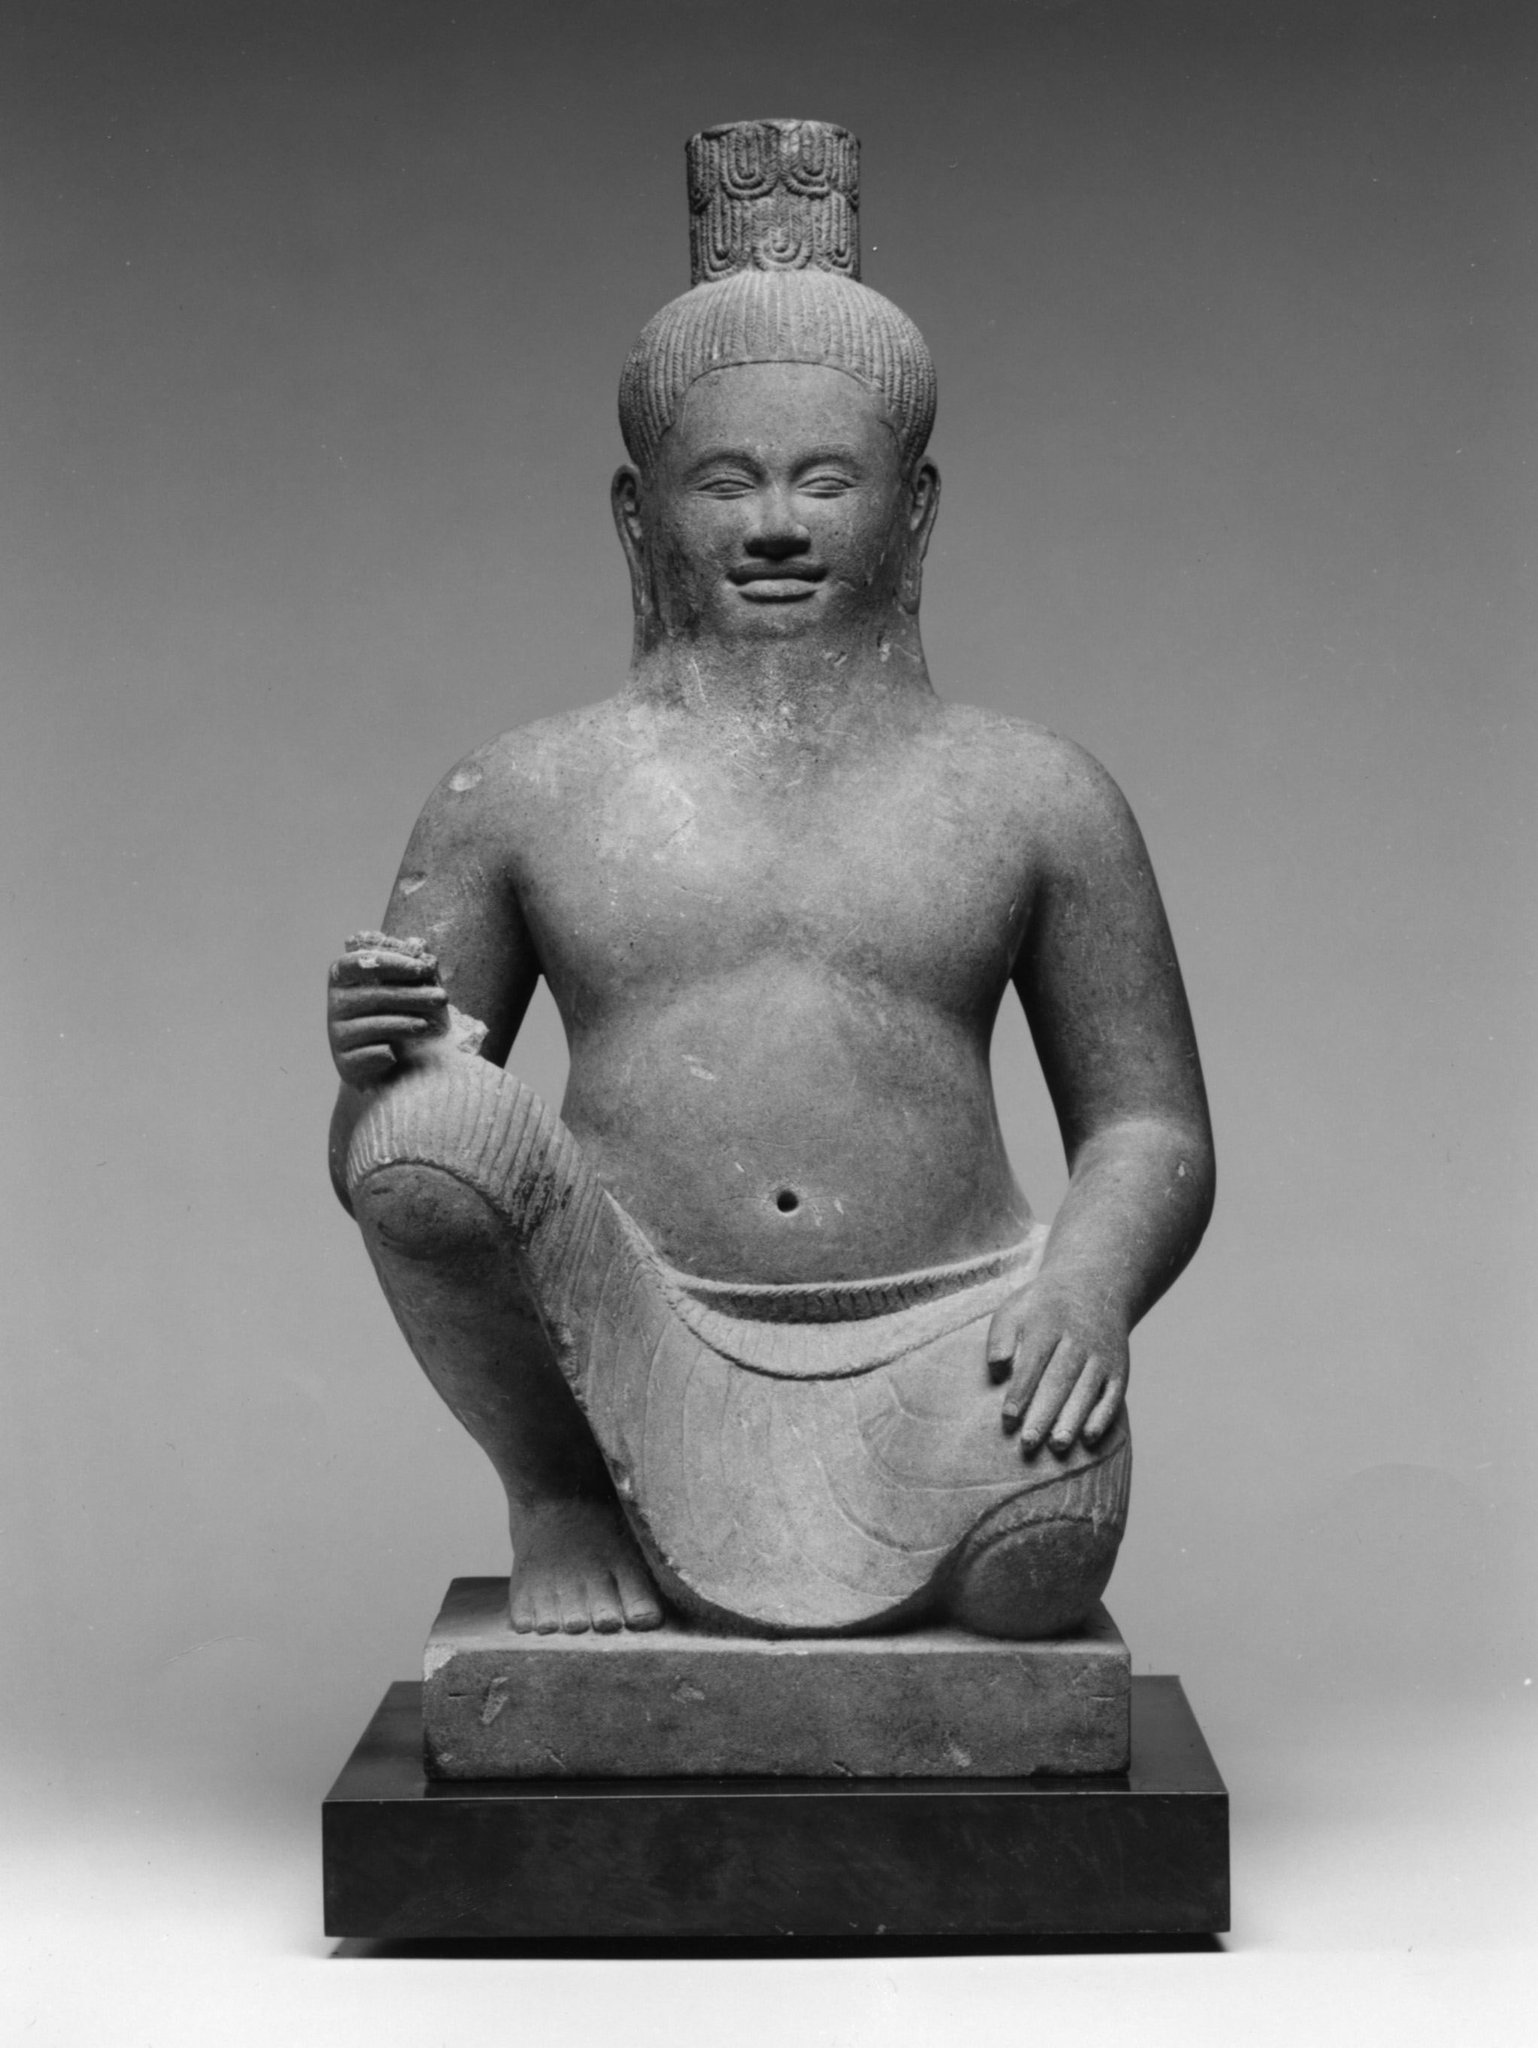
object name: figure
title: Seated Divine Sage Agastya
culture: cambodian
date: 975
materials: stone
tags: shiva,hinduism